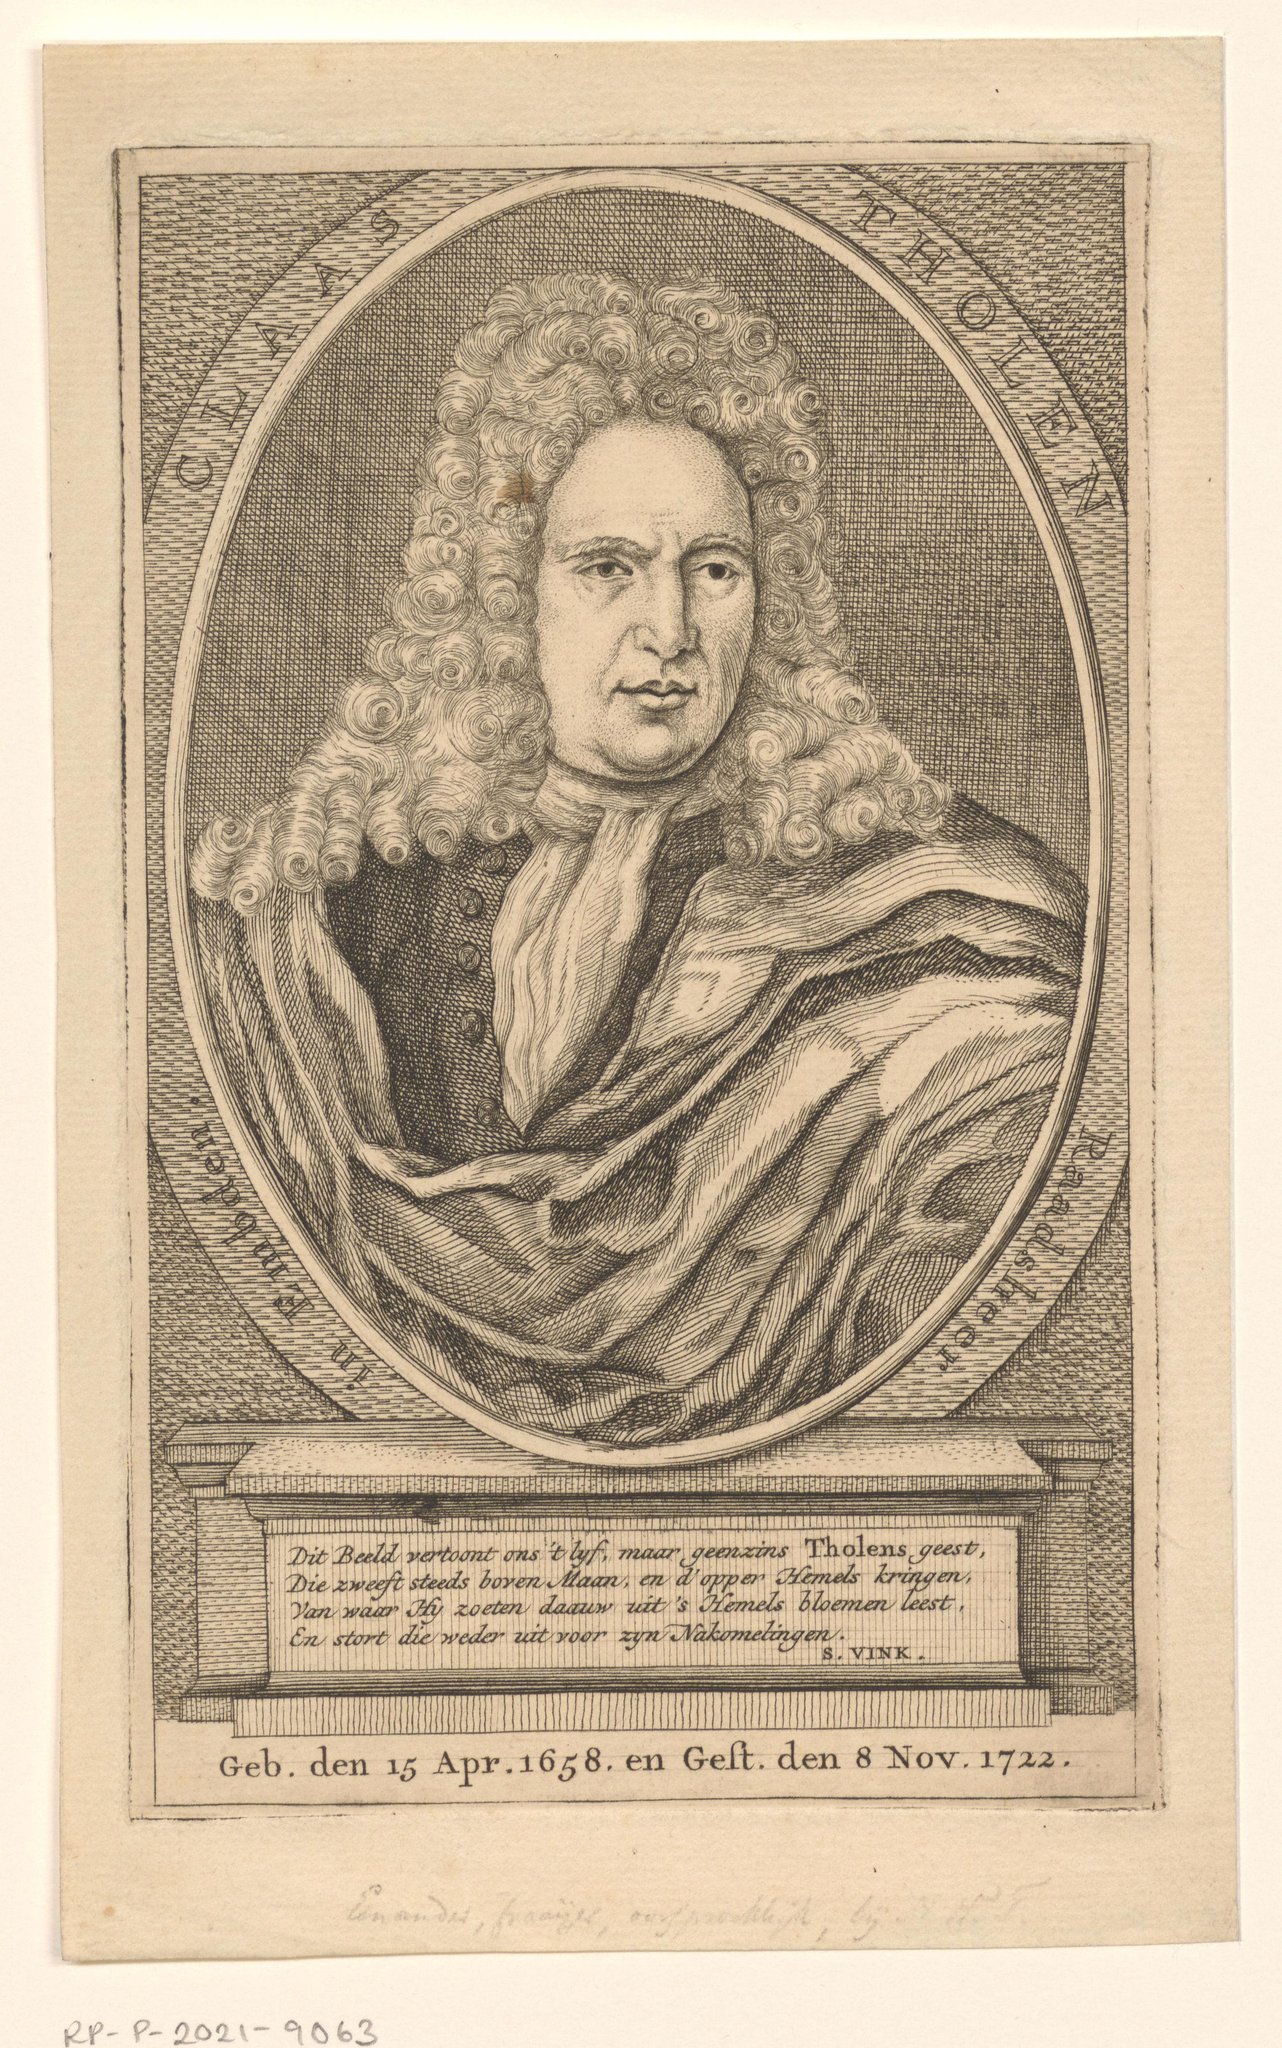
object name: print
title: Portret van Claes Tholen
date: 1722-1740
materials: paper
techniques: engraving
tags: historical persons